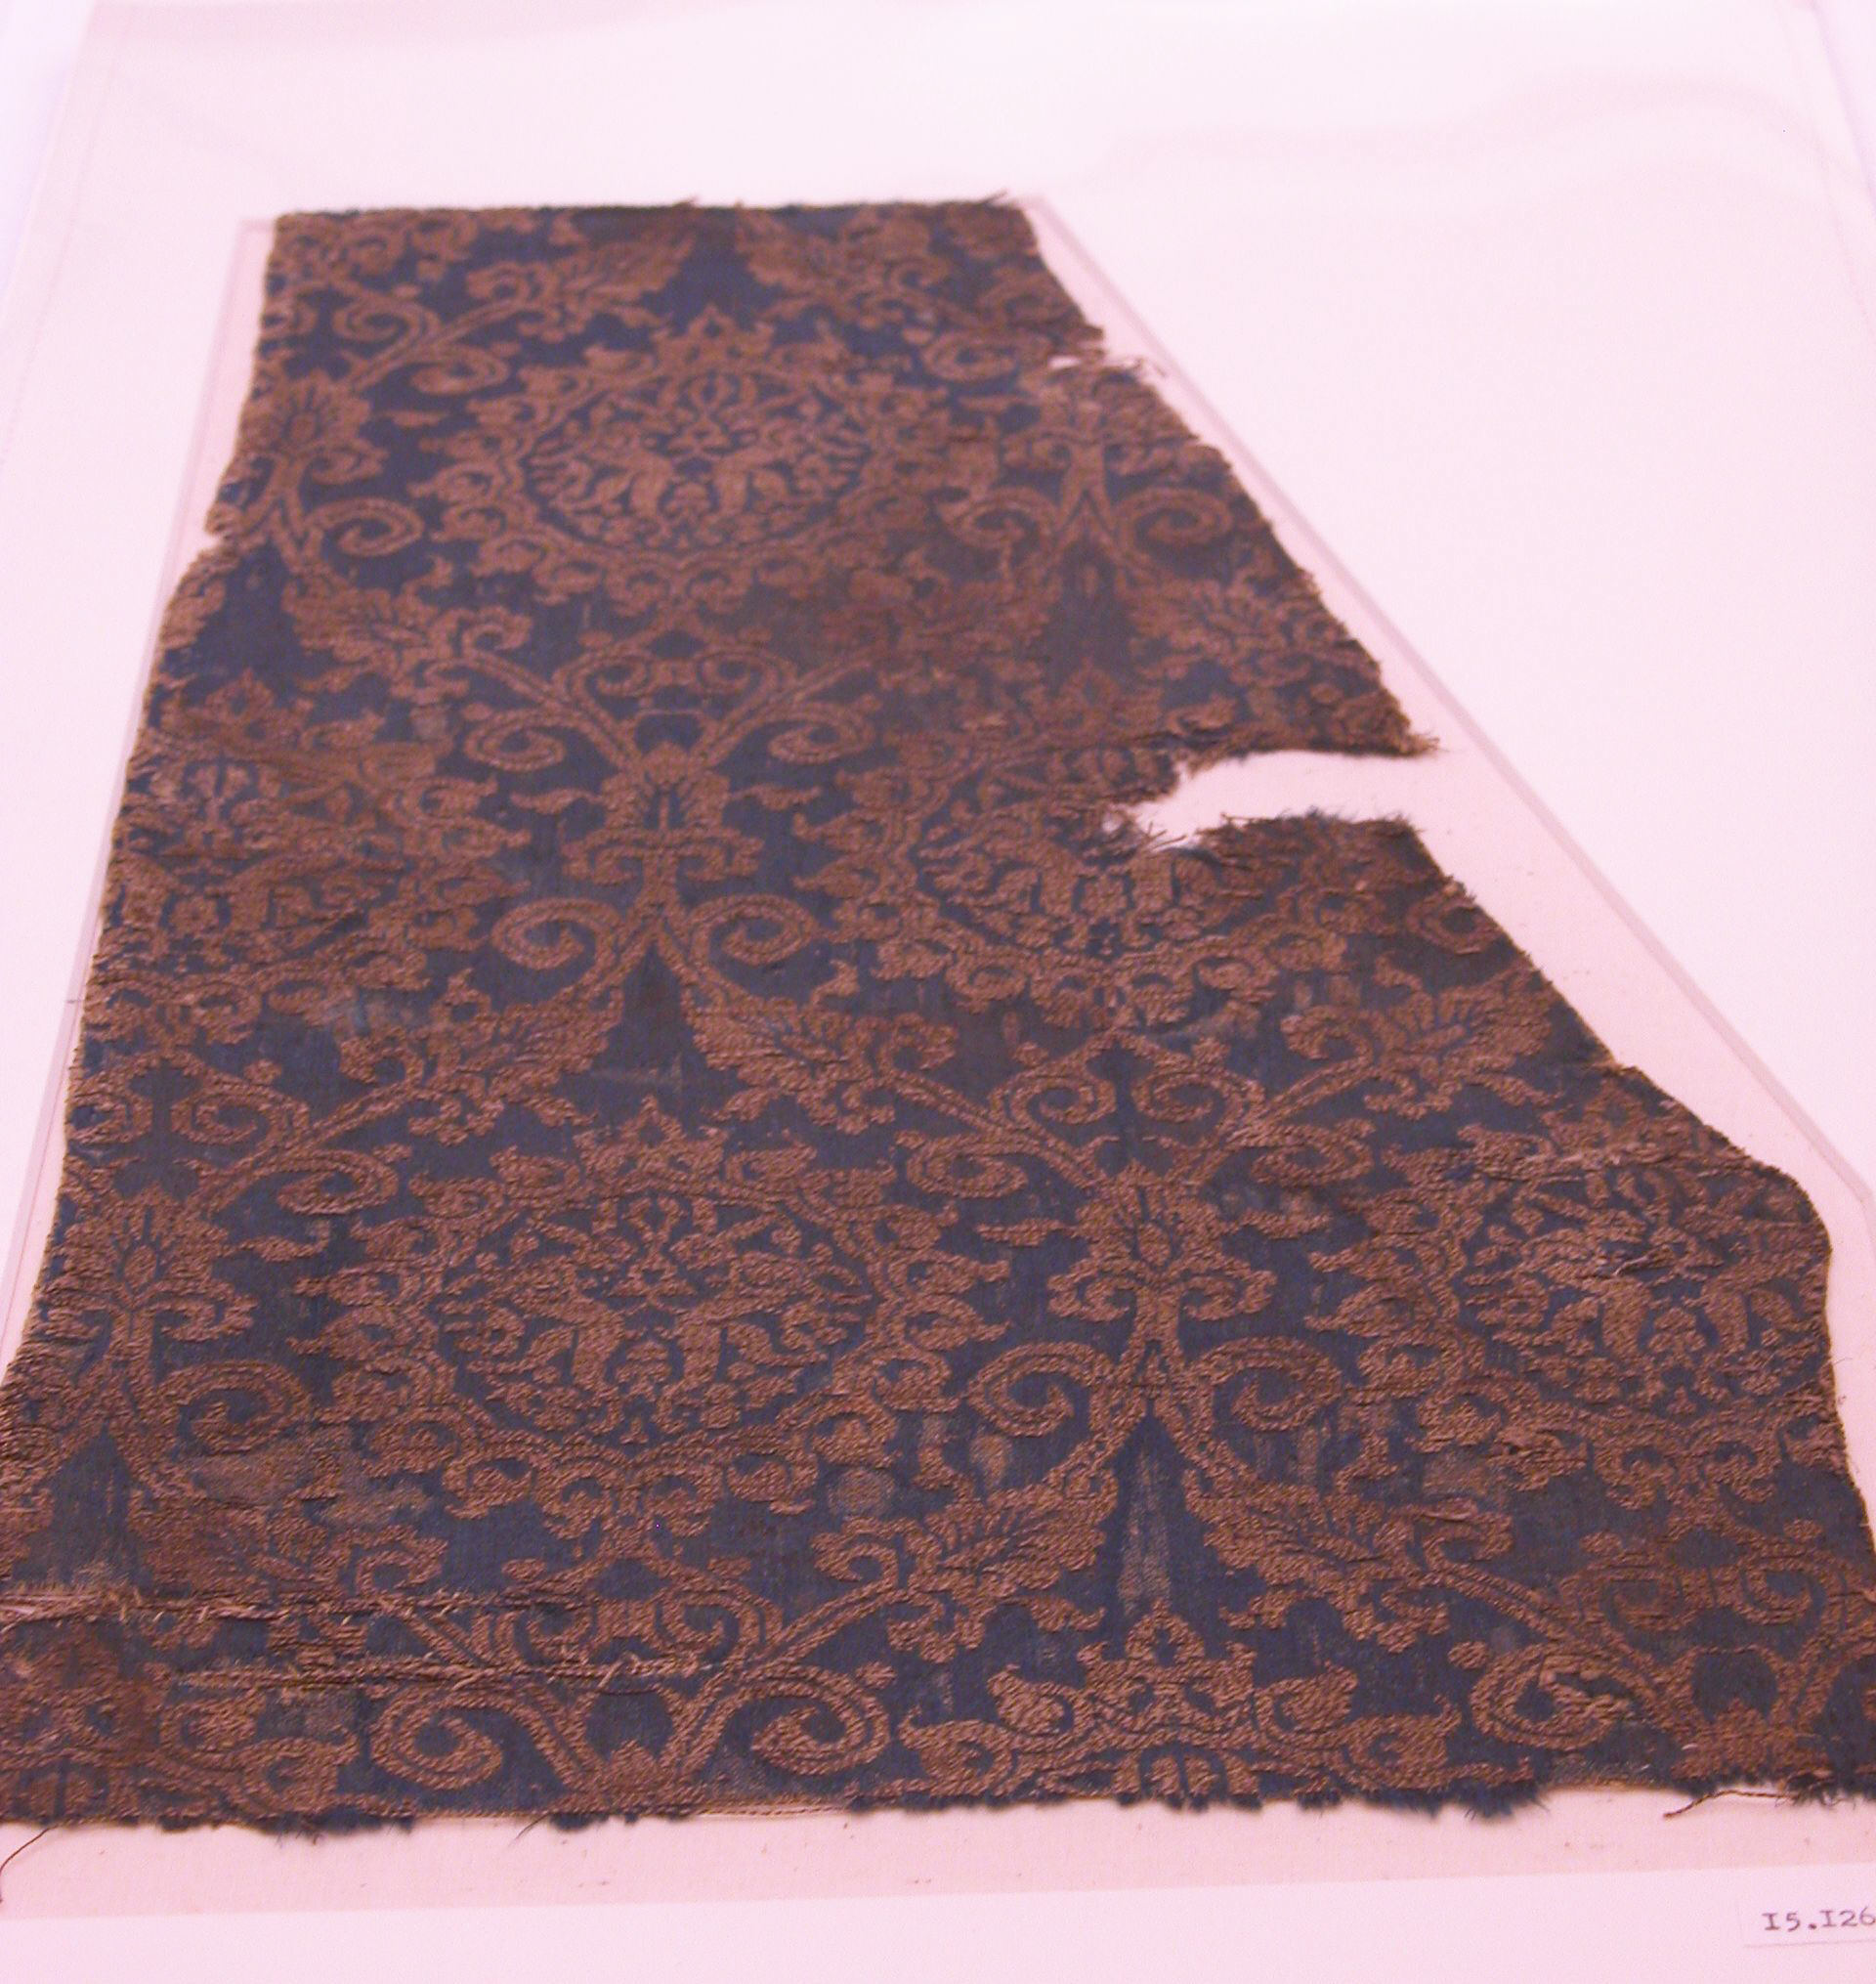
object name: textile fragment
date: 1301-1400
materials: silk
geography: italy